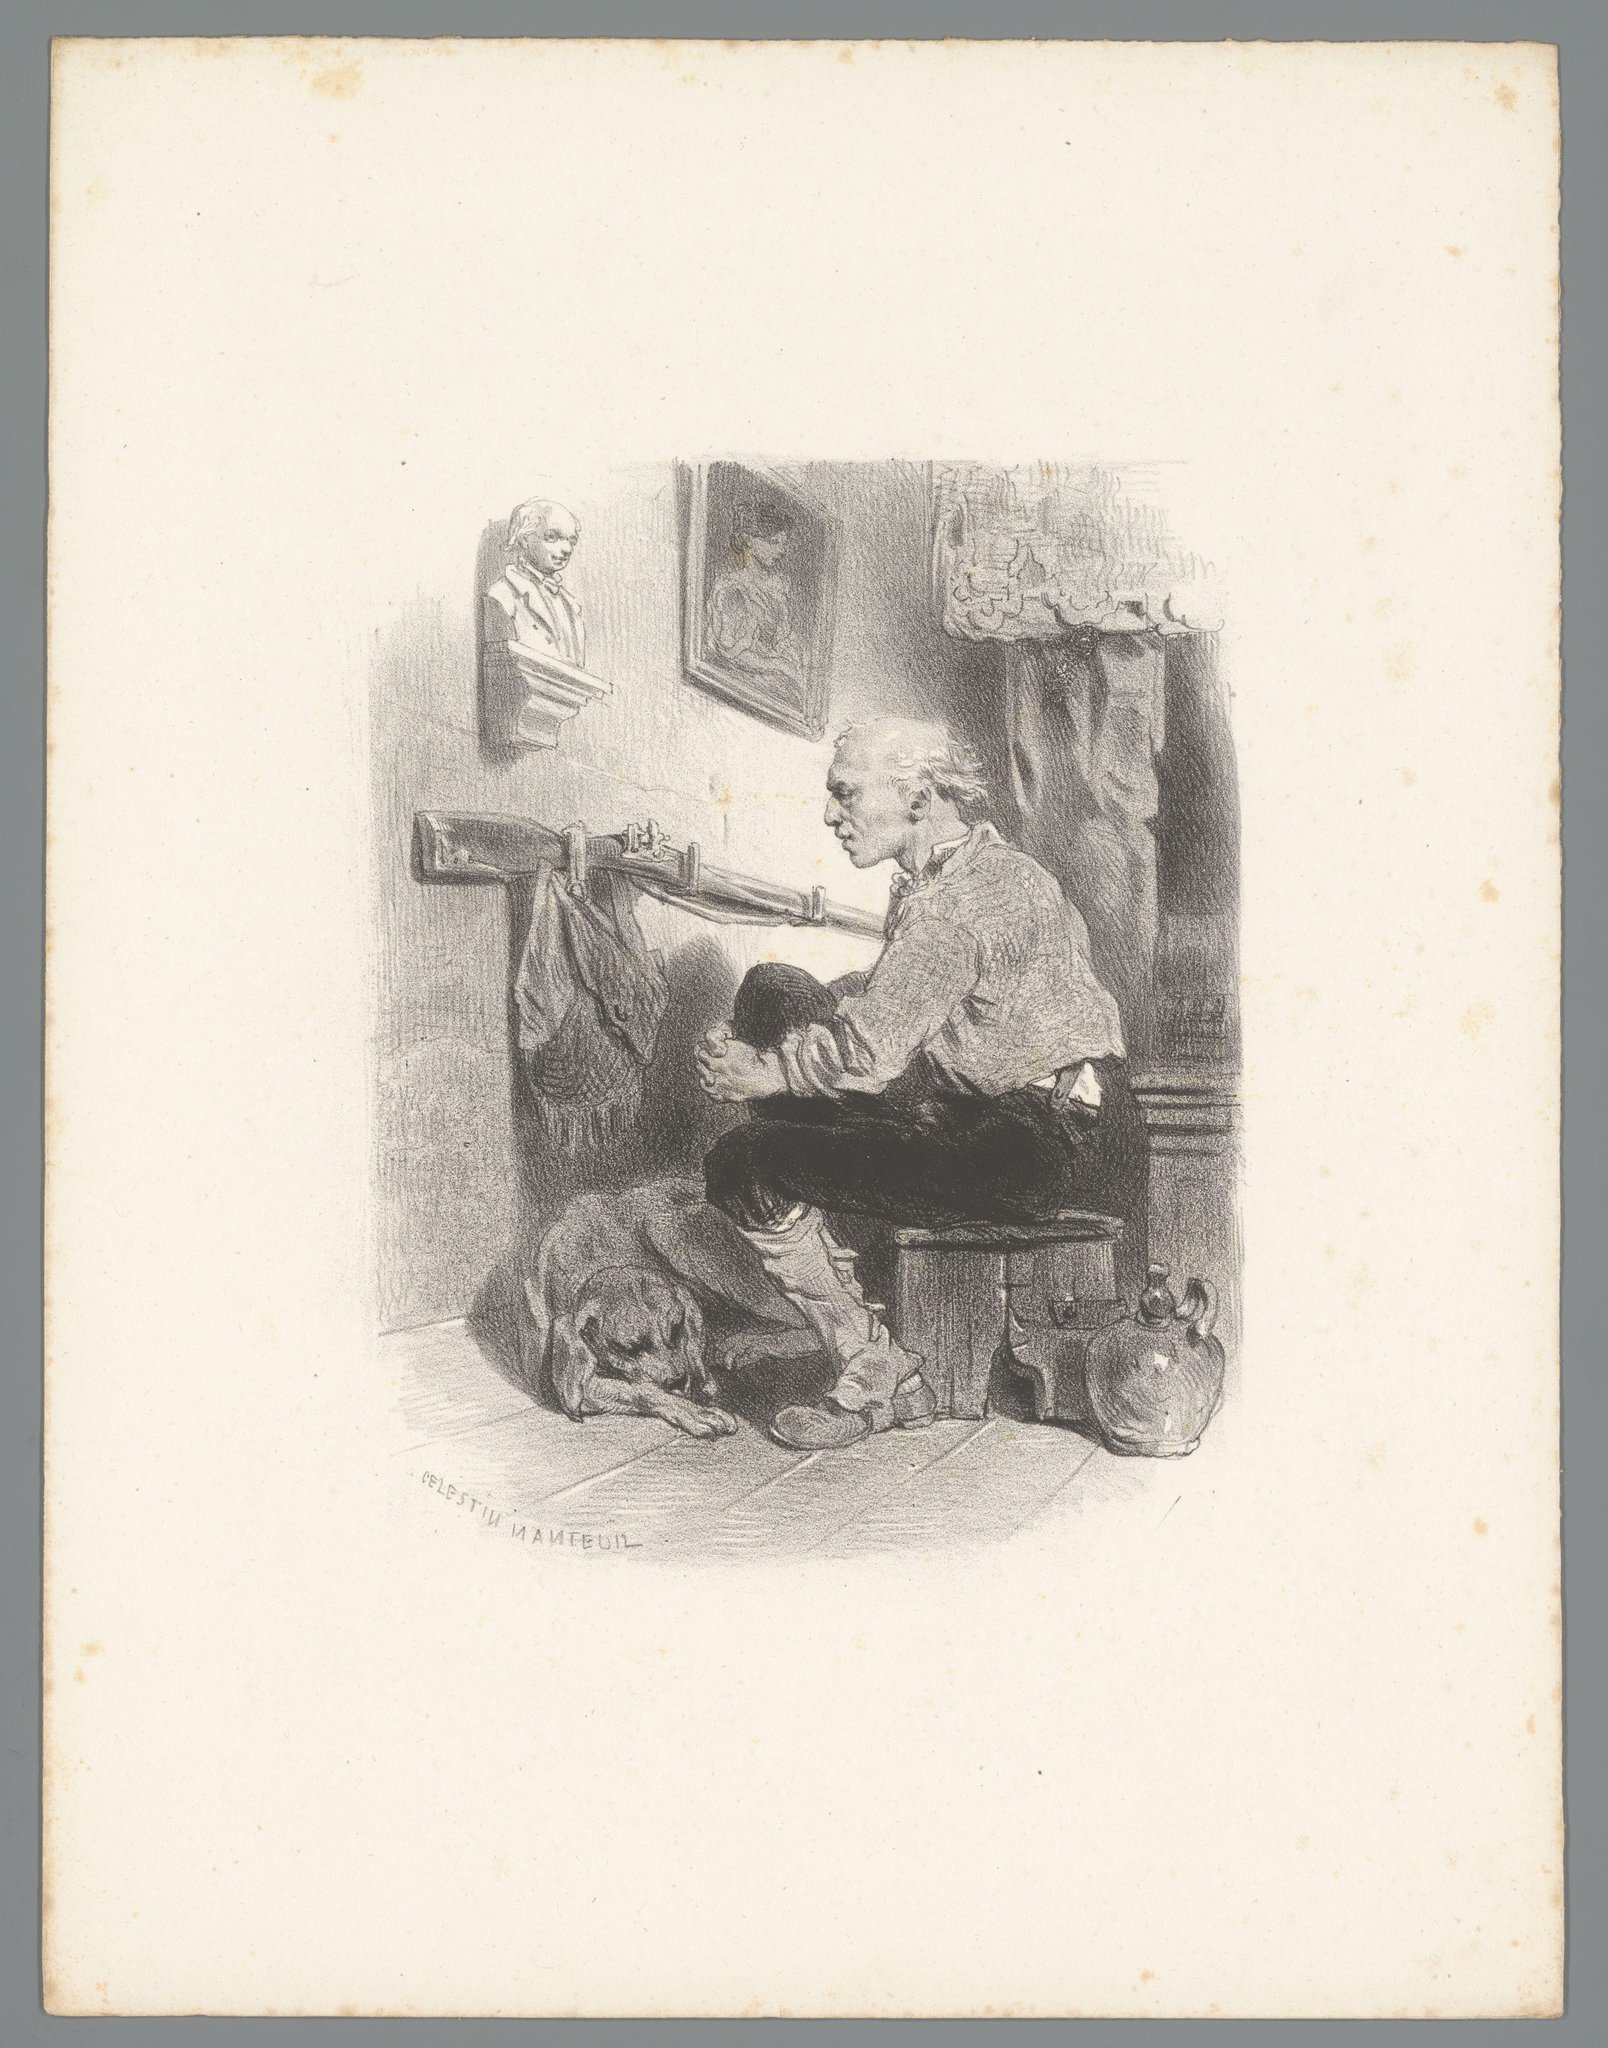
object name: print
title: Man zittend op een kruk met een hond aan zijn voeten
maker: célestin françois nanteuil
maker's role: print maker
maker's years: 1813-1873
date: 1823-1873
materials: paper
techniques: lithograph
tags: adult man, firearms: rifle, dog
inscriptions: collector's mark: Lugt 964